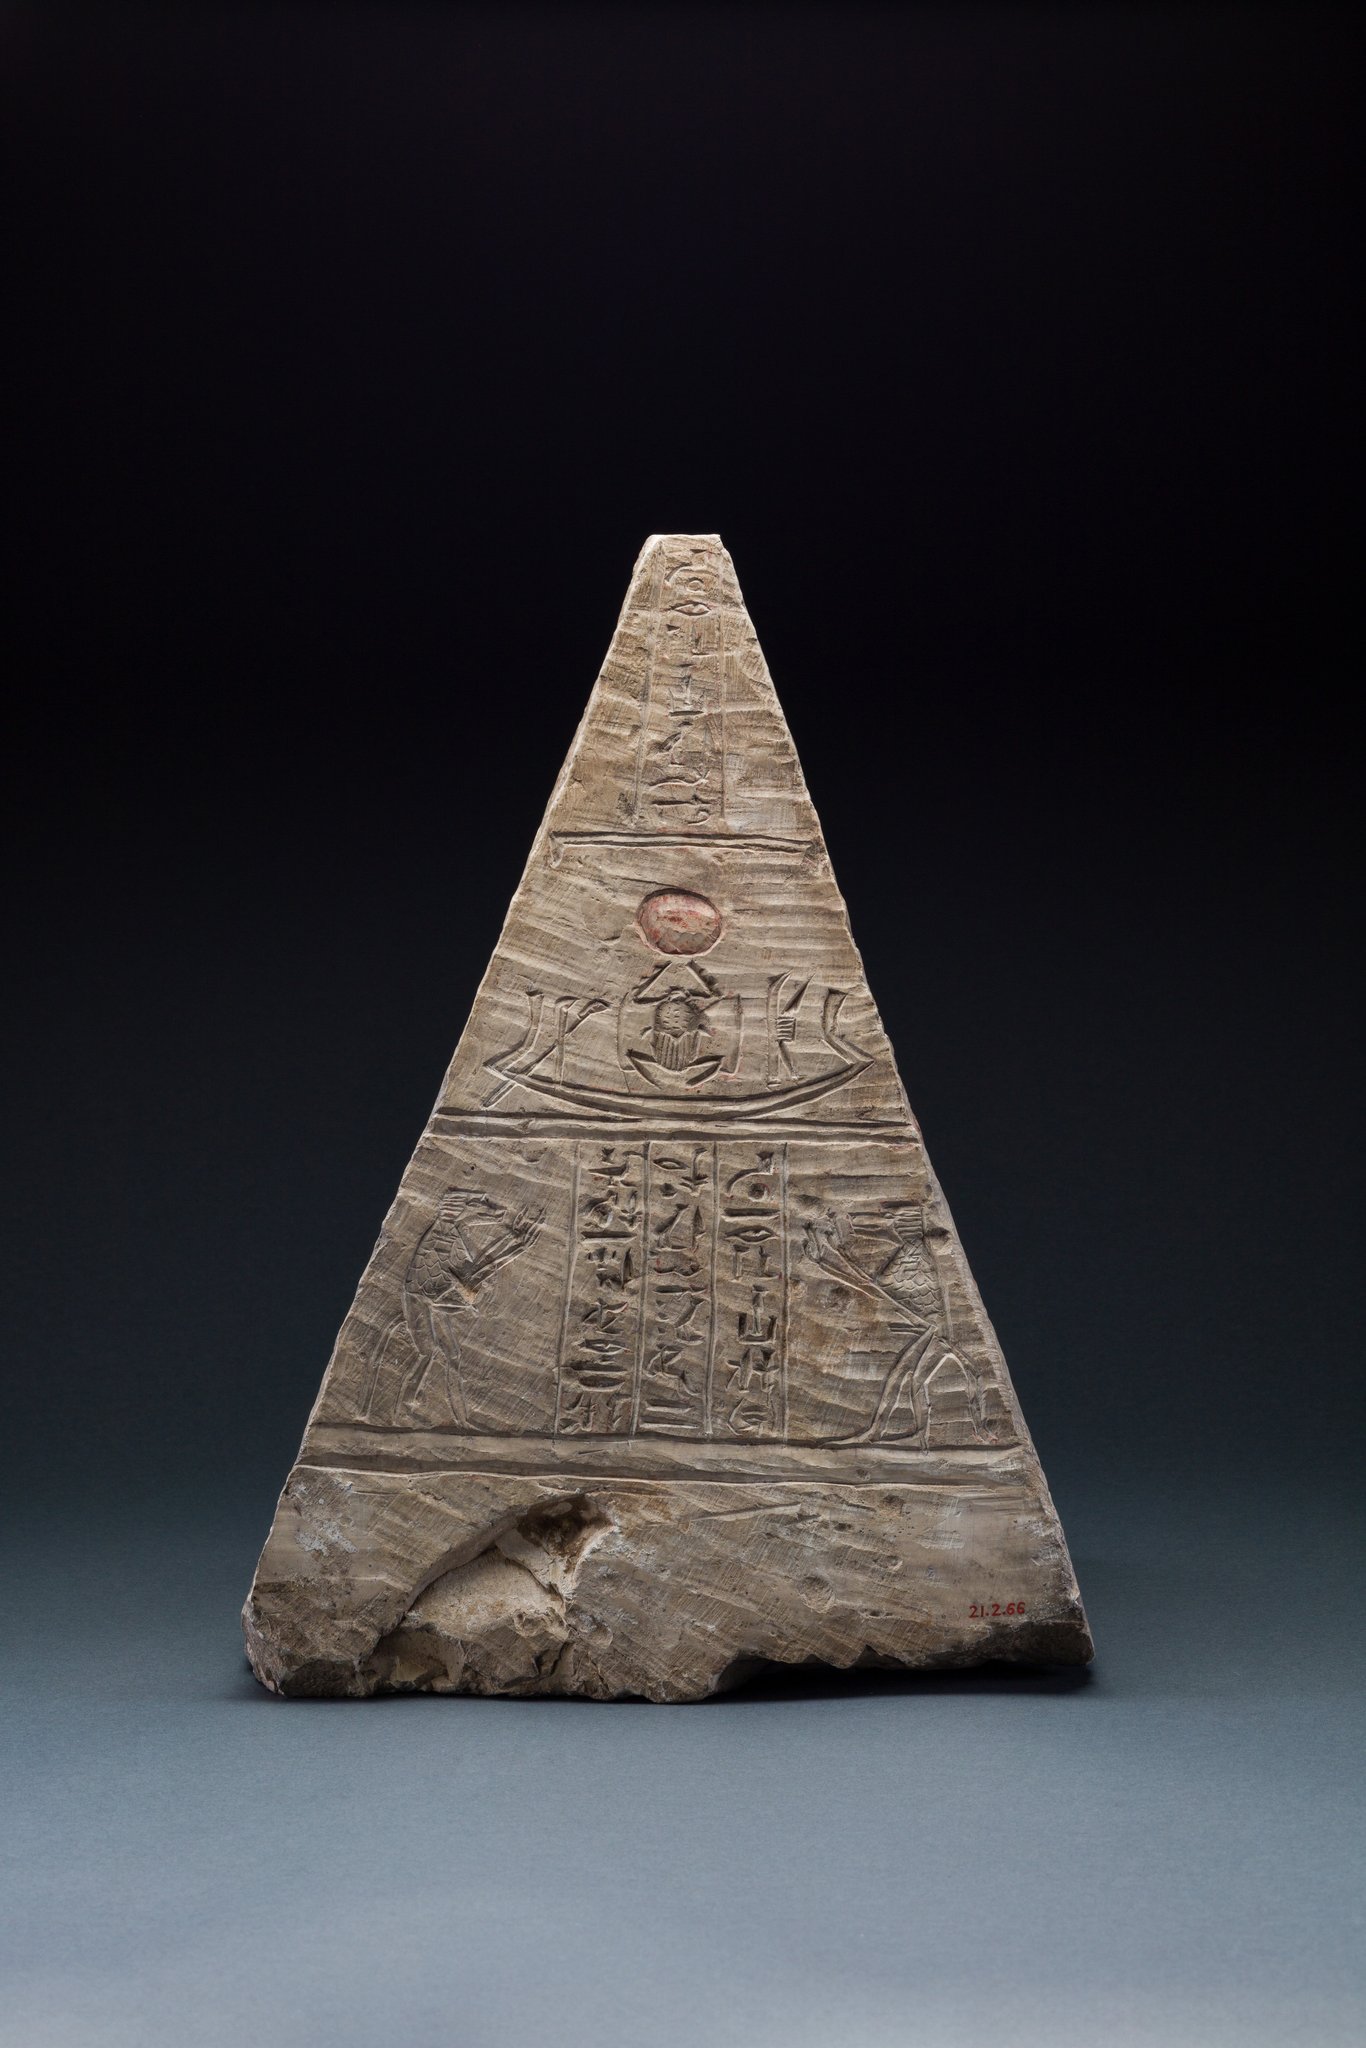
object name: pyramidion, iufaa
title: Pyramidion of Iufaa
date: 664-525 BCE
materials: limestone, paint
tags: animals,men,hieroglyphs